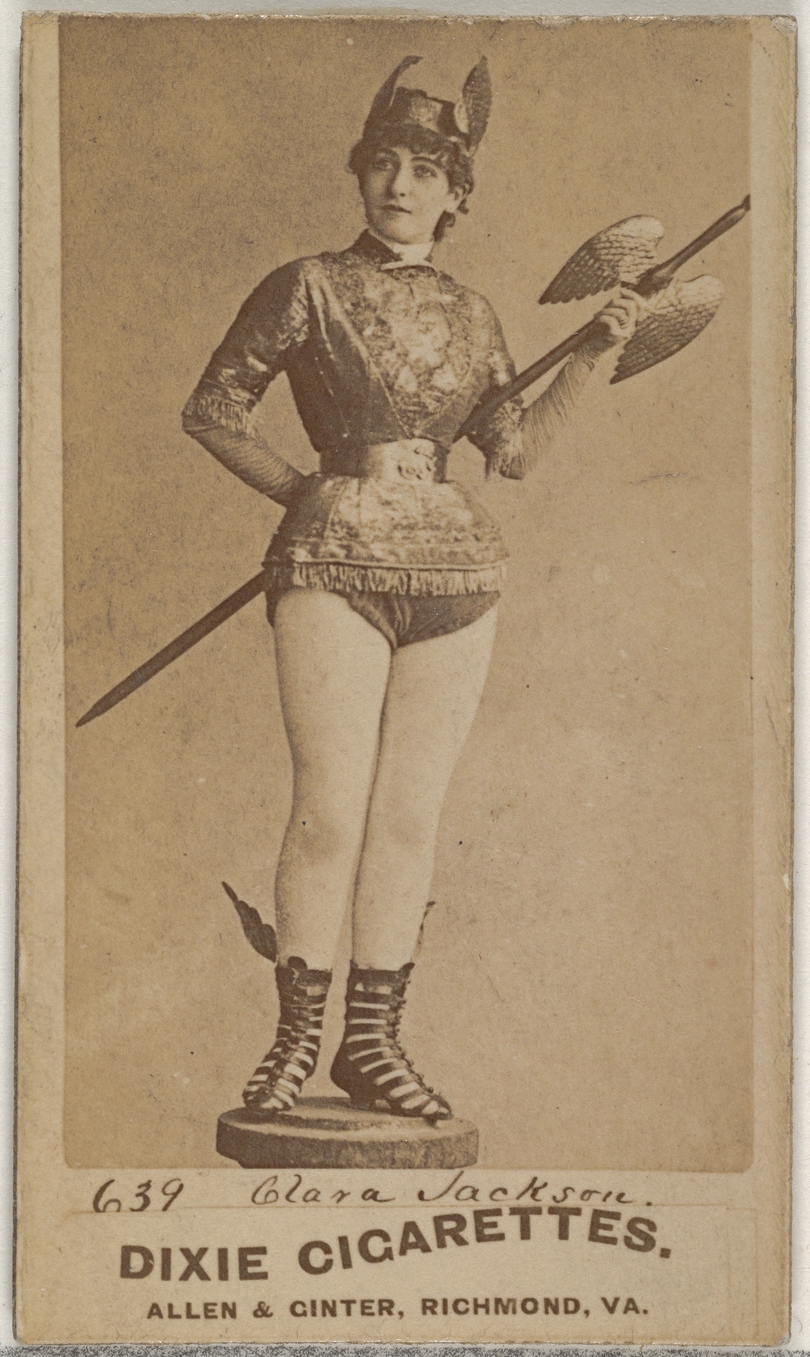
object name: photograph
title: Card 639, Clara Jackson, from the Actors and Actresses series (N45, Type 7) for Dixie Cigarettes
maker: allen & ginter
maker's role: publisher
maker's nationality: american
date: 1888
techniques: albumen silver print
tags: portraits,women,actresses